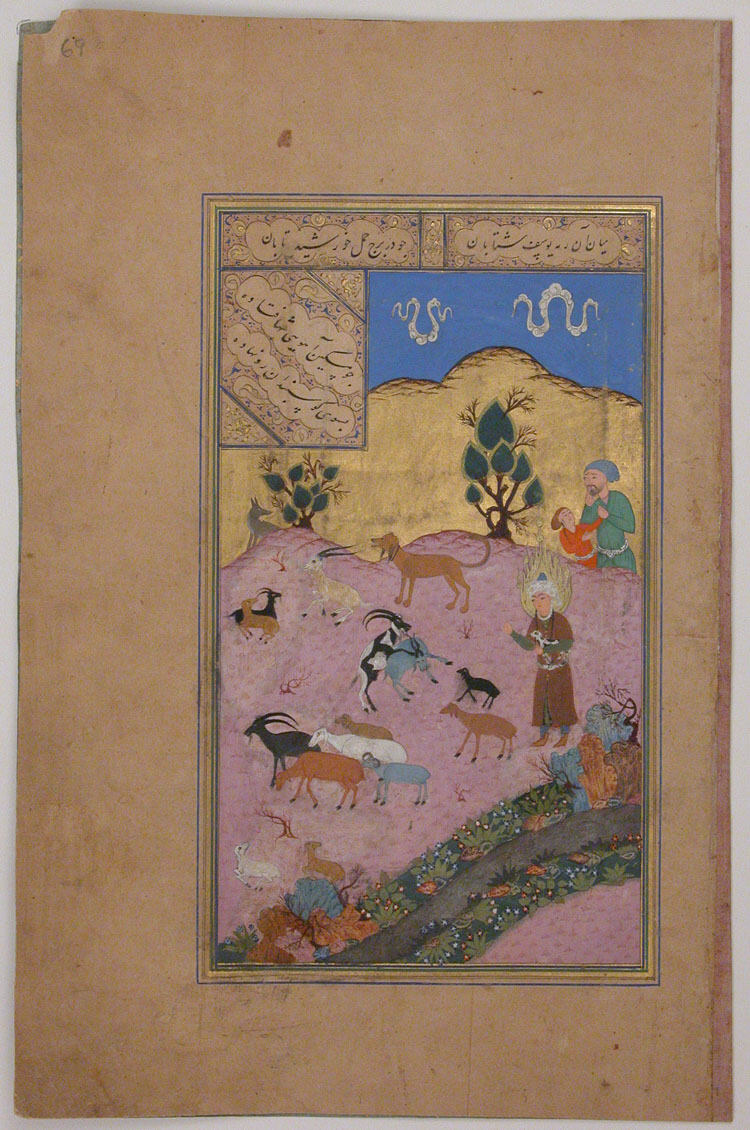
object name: folio from an illustrated manuscript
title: "Yusuf Tending the Flocks", Folio of a Yusuf and Zulaykha of Jami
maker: maulana nur al-din `abd al-rahman jami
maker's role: author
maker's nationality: iranian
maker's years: 1414-1492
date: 1523-1524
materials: gold, ink, paper, silver, watercolor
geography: uzbekistan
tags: animals,men